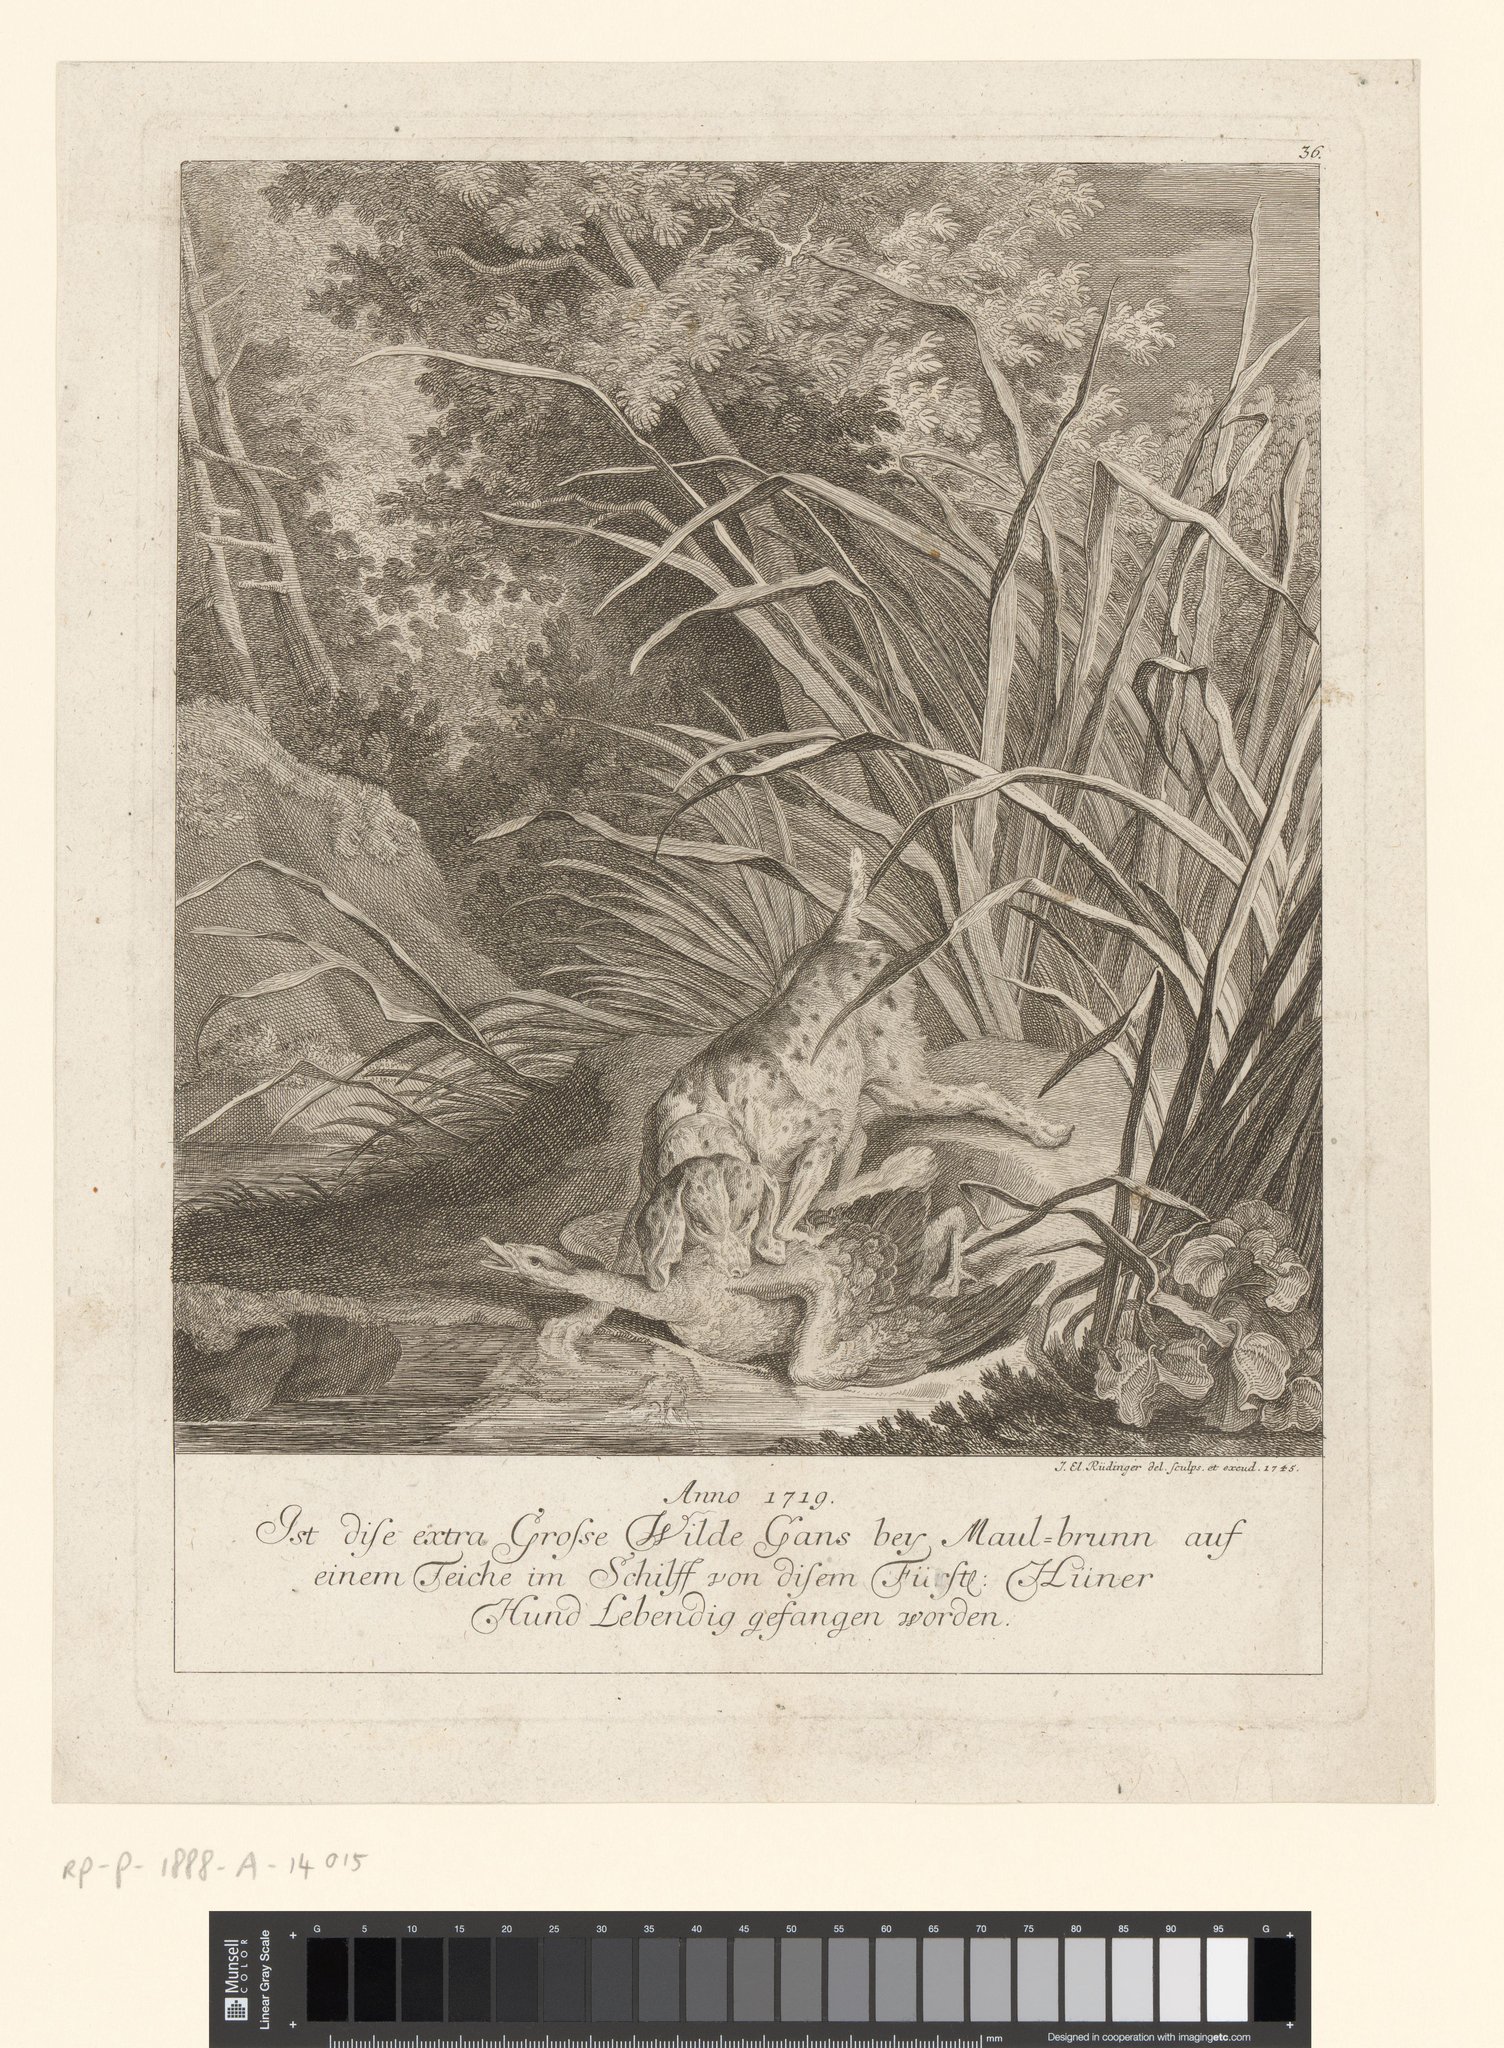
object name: print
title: Patrijshond vangt een bijzonder grote gans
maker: johann elias ridinger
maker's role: draughtsman, painter, print maker, publisher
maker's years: 1698-1767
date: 1745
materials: paper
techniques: etching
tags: water-birds: goose, hunting dogs, forest, wood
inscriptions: collector's mark: Lugt 2228